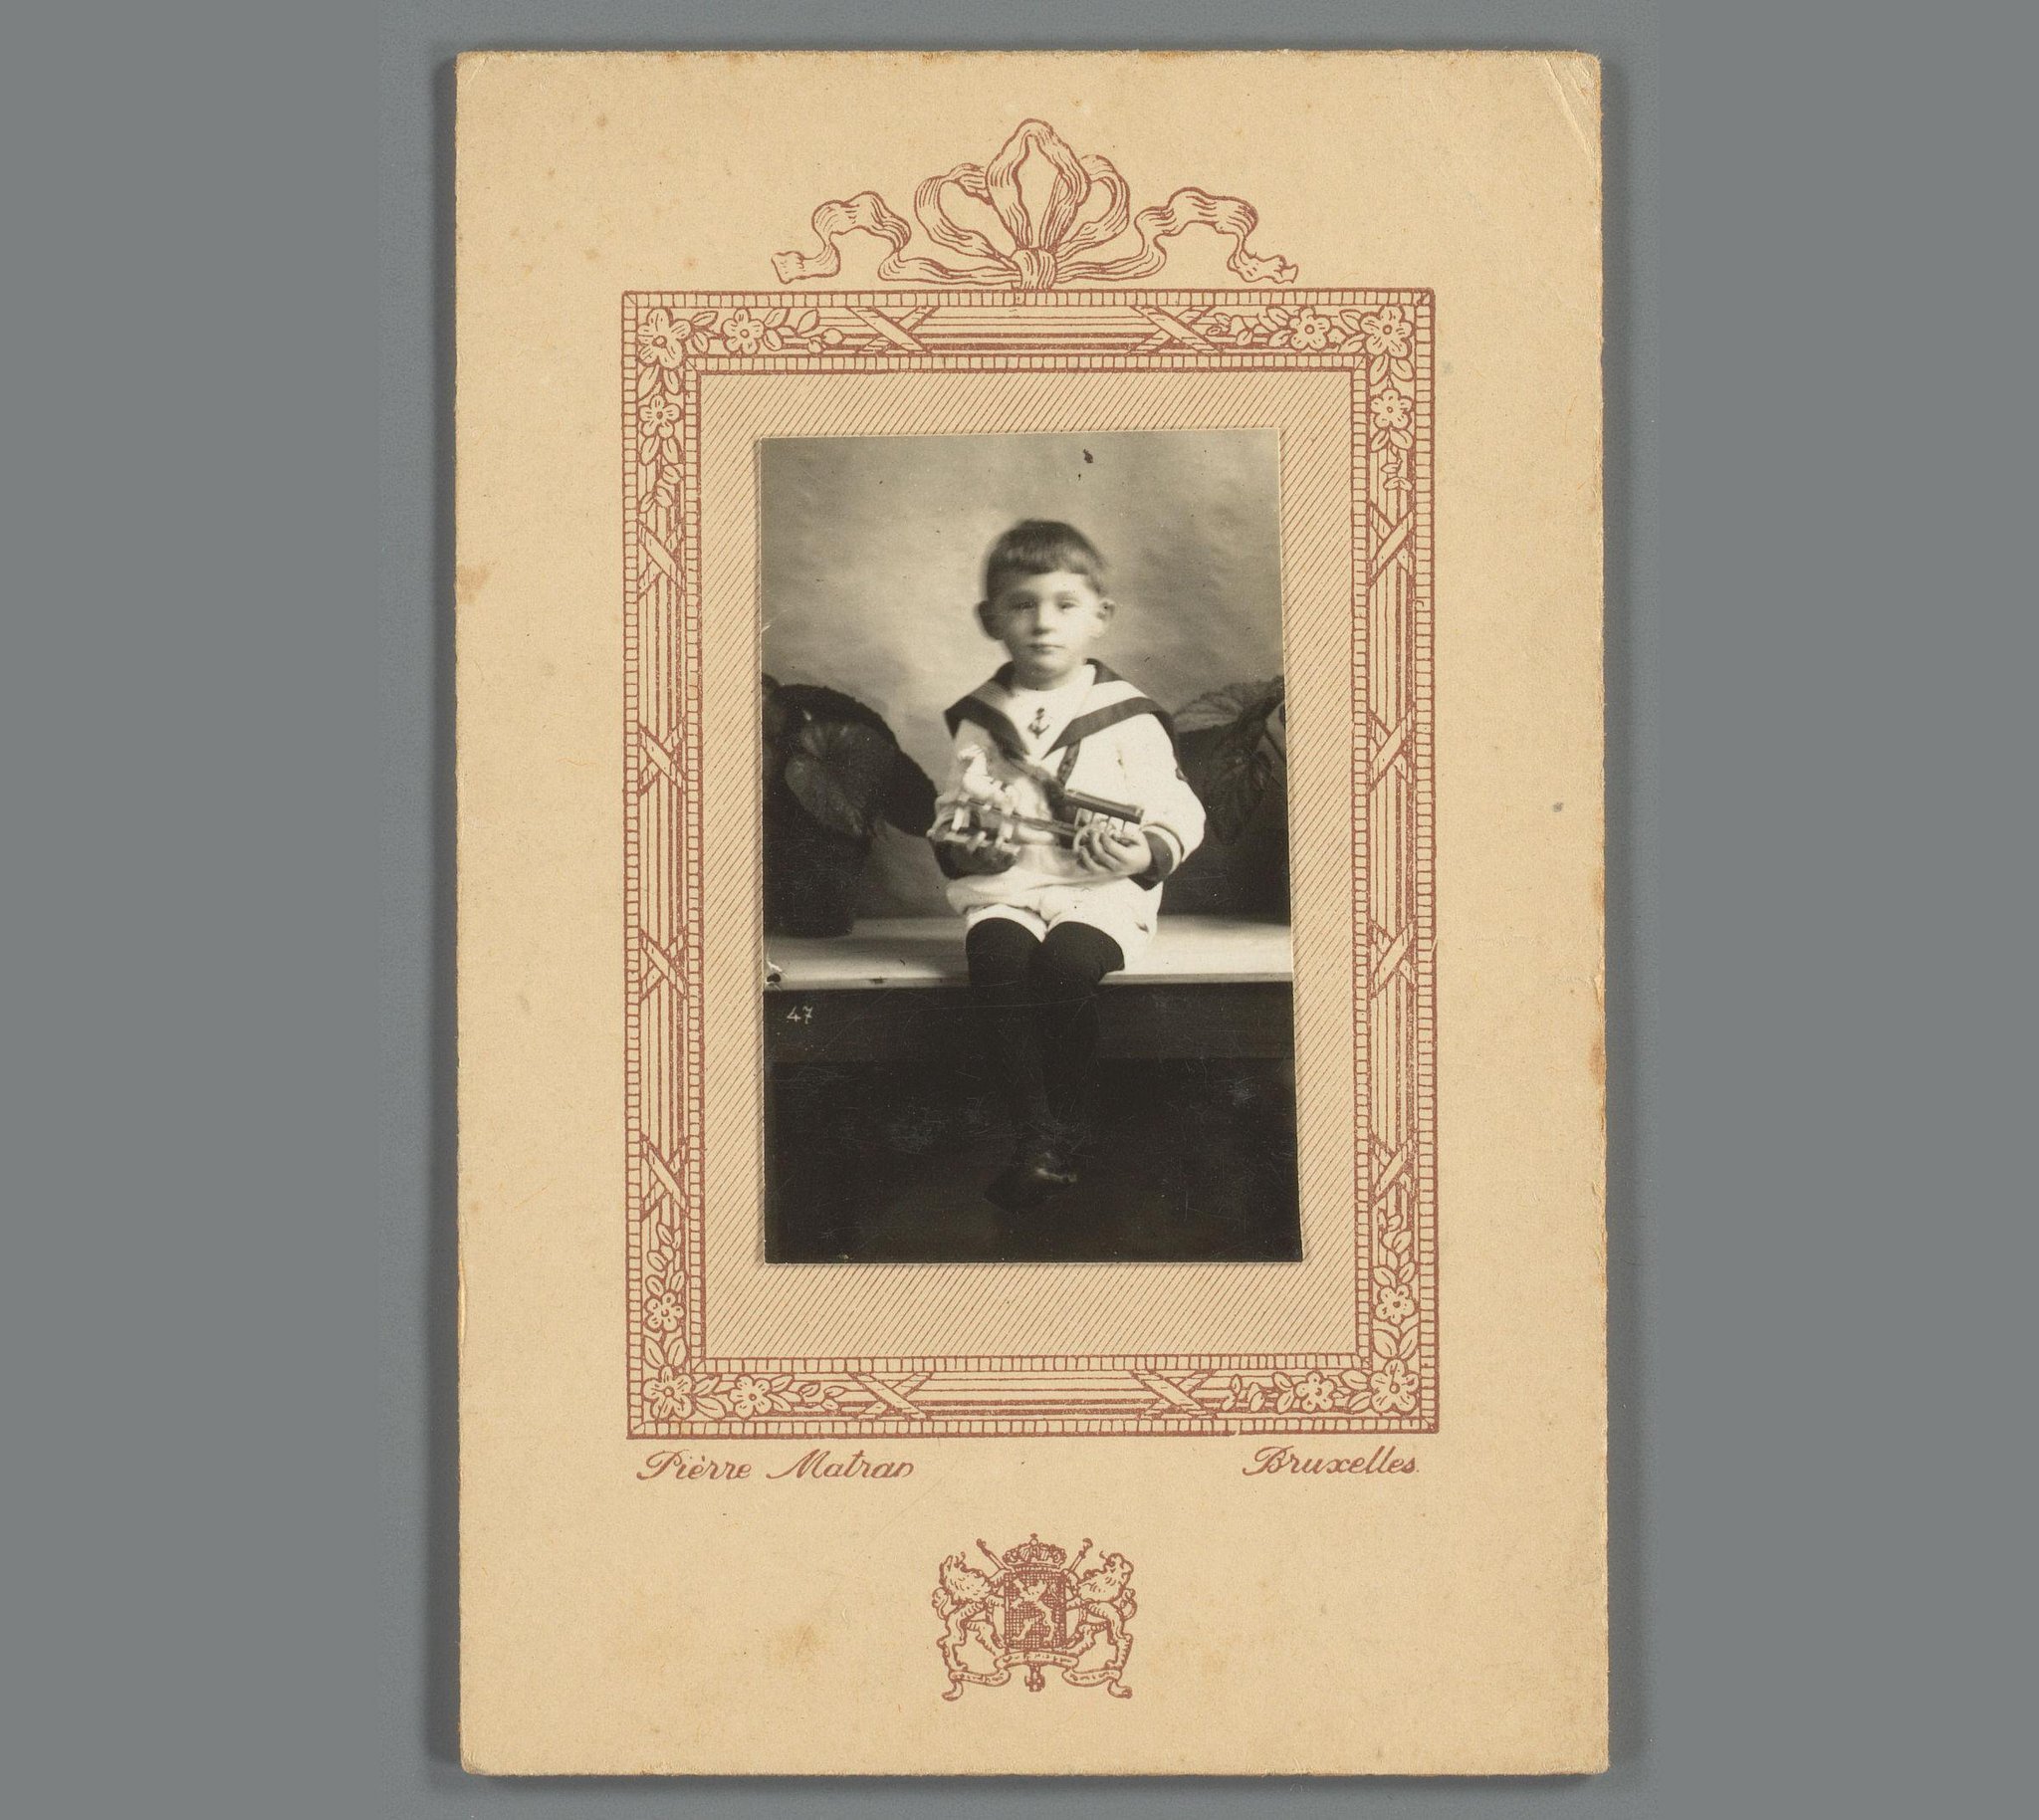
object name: photograph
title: Portret van een onbekende jongen met speelgoedpaard en -wagen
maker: pierre matran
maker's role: fotograaf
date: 1911-1914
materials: paper, cardboard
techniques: gelatin silver print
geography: brussels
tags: boy (child between toddler and youth), anonymous historical person portrayed, (playing with) dolls, toy animals, brussels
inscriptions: inscription: ‘Pierre Matran Bruxelles.’